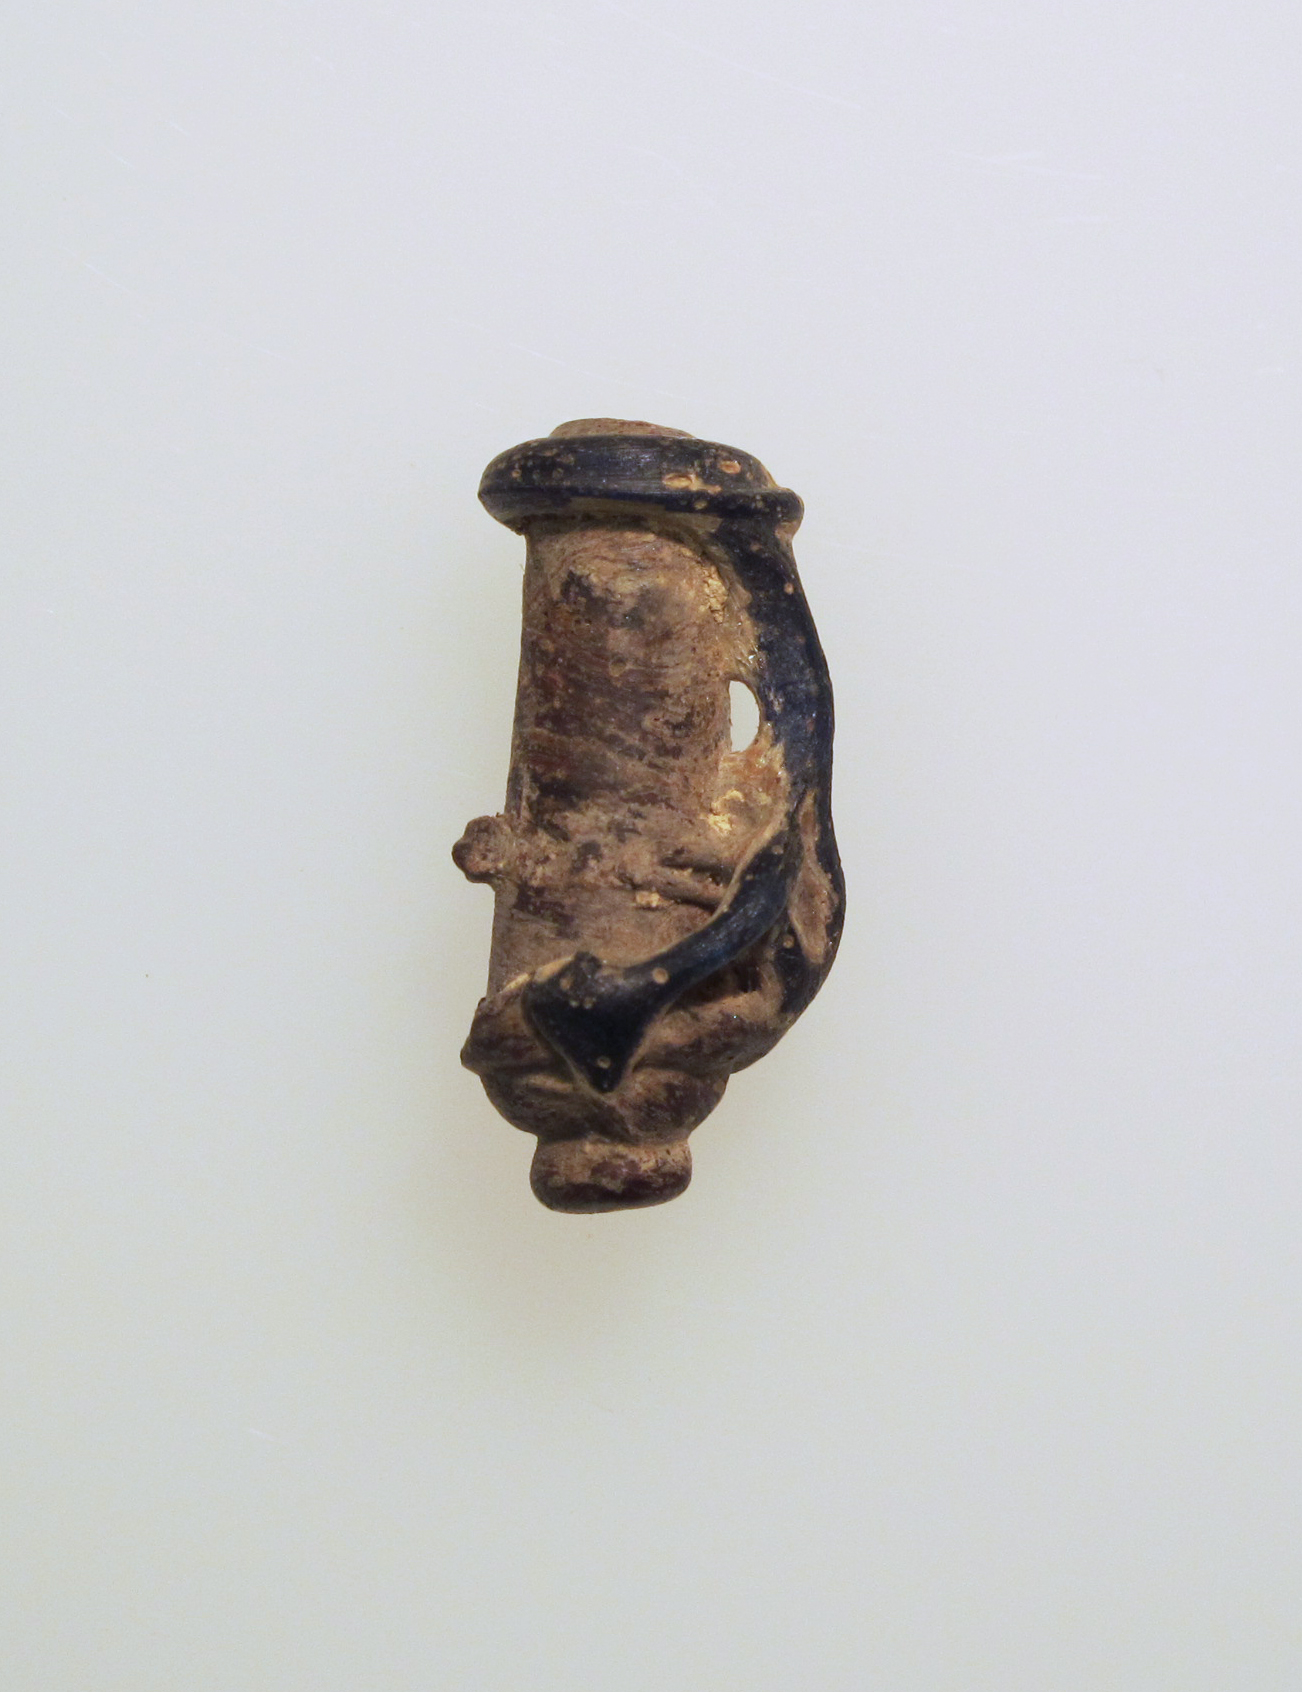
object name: pendant in the form of a vase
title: Glass pendant in the form of a vase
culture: roman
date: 301-433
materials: glass